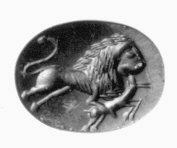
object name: stamp seal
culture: parthian or sasanian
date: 201-300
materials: jasper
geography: iran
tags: lions